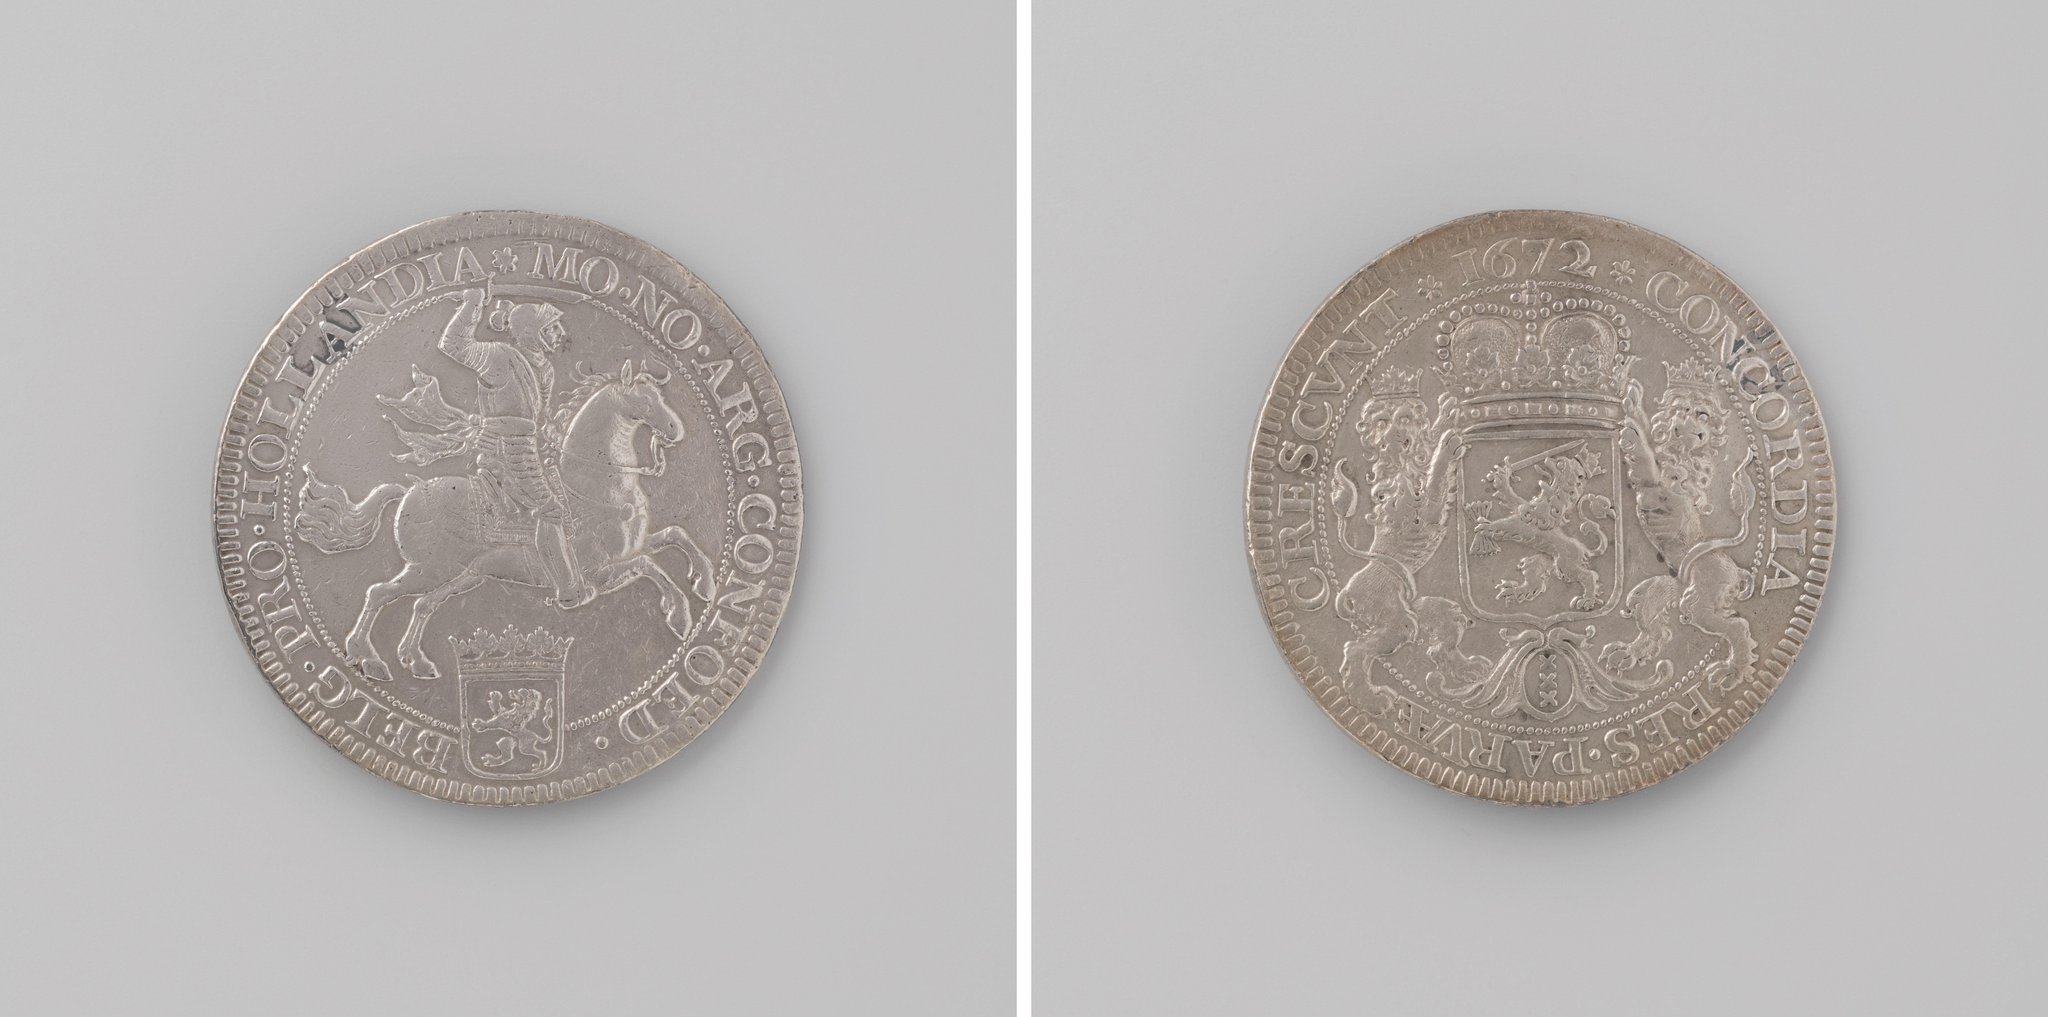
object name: silver rider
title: Zilveren rijder in de munt van Amsterdam geslagen van het opgebrachte zilver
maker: christoffel adolphi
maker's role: medailleur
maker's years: 1630-1684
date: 1673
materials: silver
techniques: striking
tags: amsterdam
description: Zilveren rijder. Voorzijde: ruiter boven wapenschild binnen omschrift. Keerzijde: gekroond wapenschild door twee gekroonde leeuwen gedragen binnen omschrift.